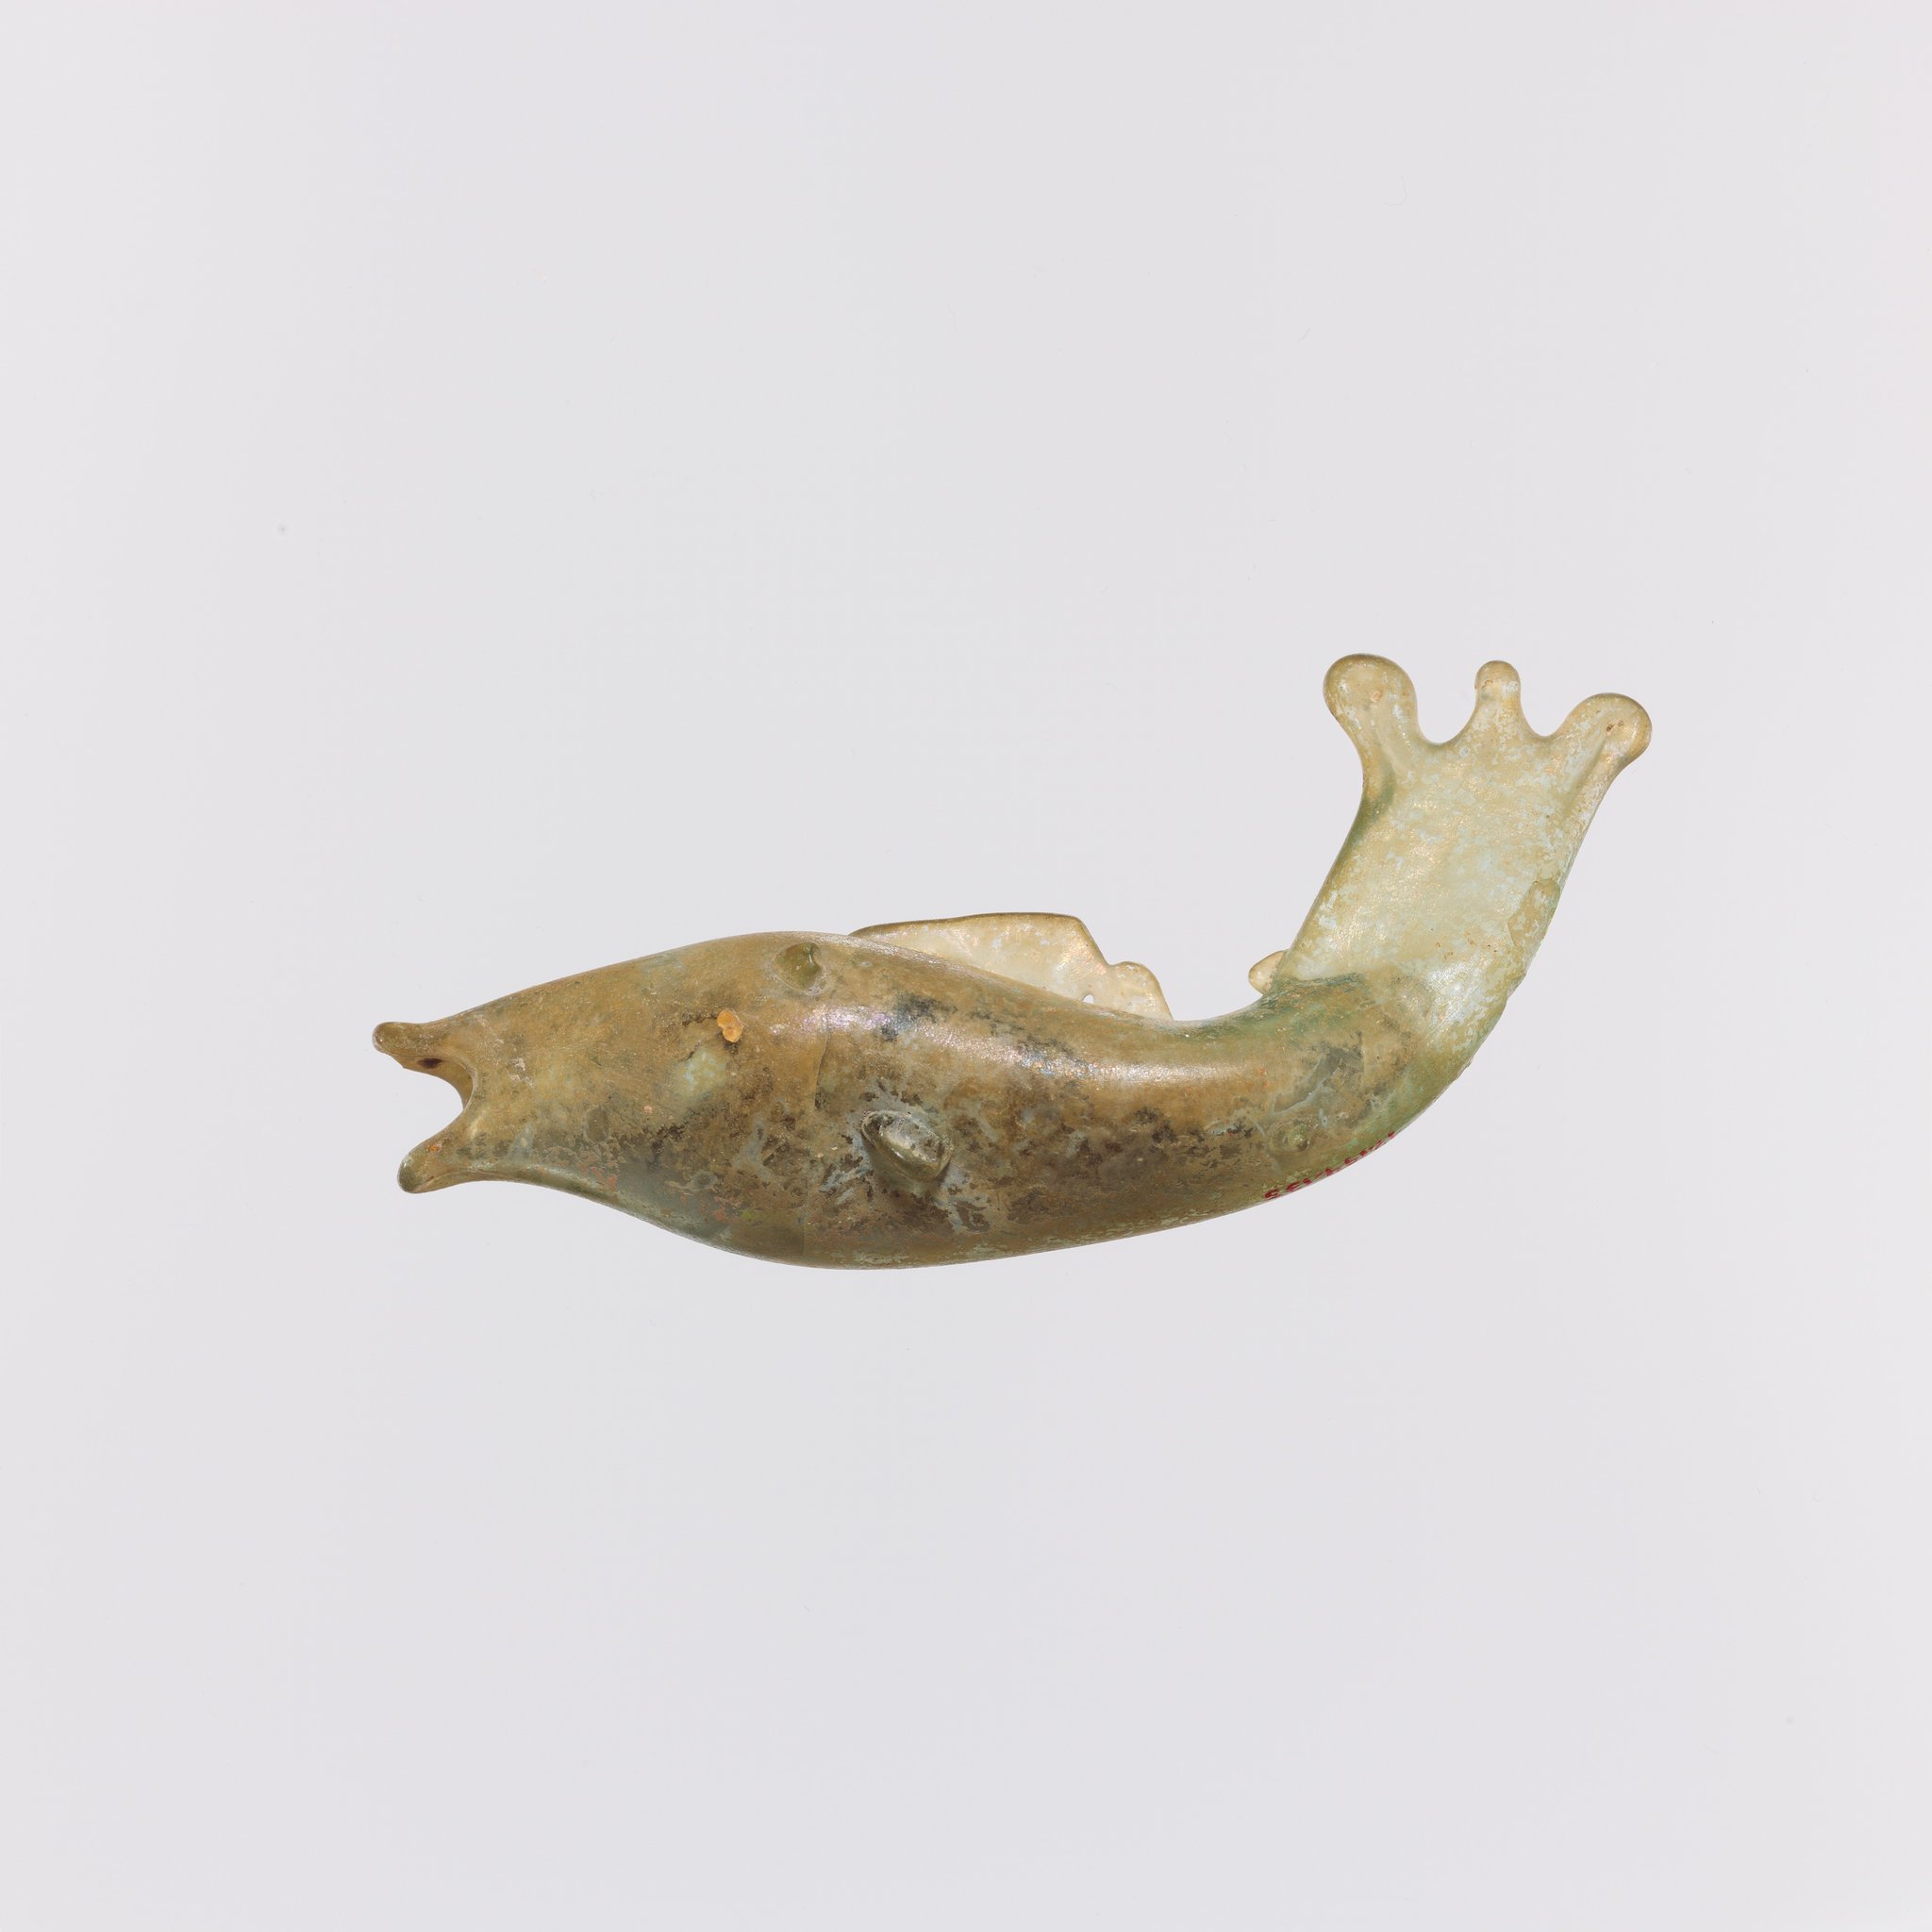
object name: bottle in the form of a fish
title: Glass bottle in the shape of a fish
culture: roman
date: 301-400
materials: glass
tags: fish